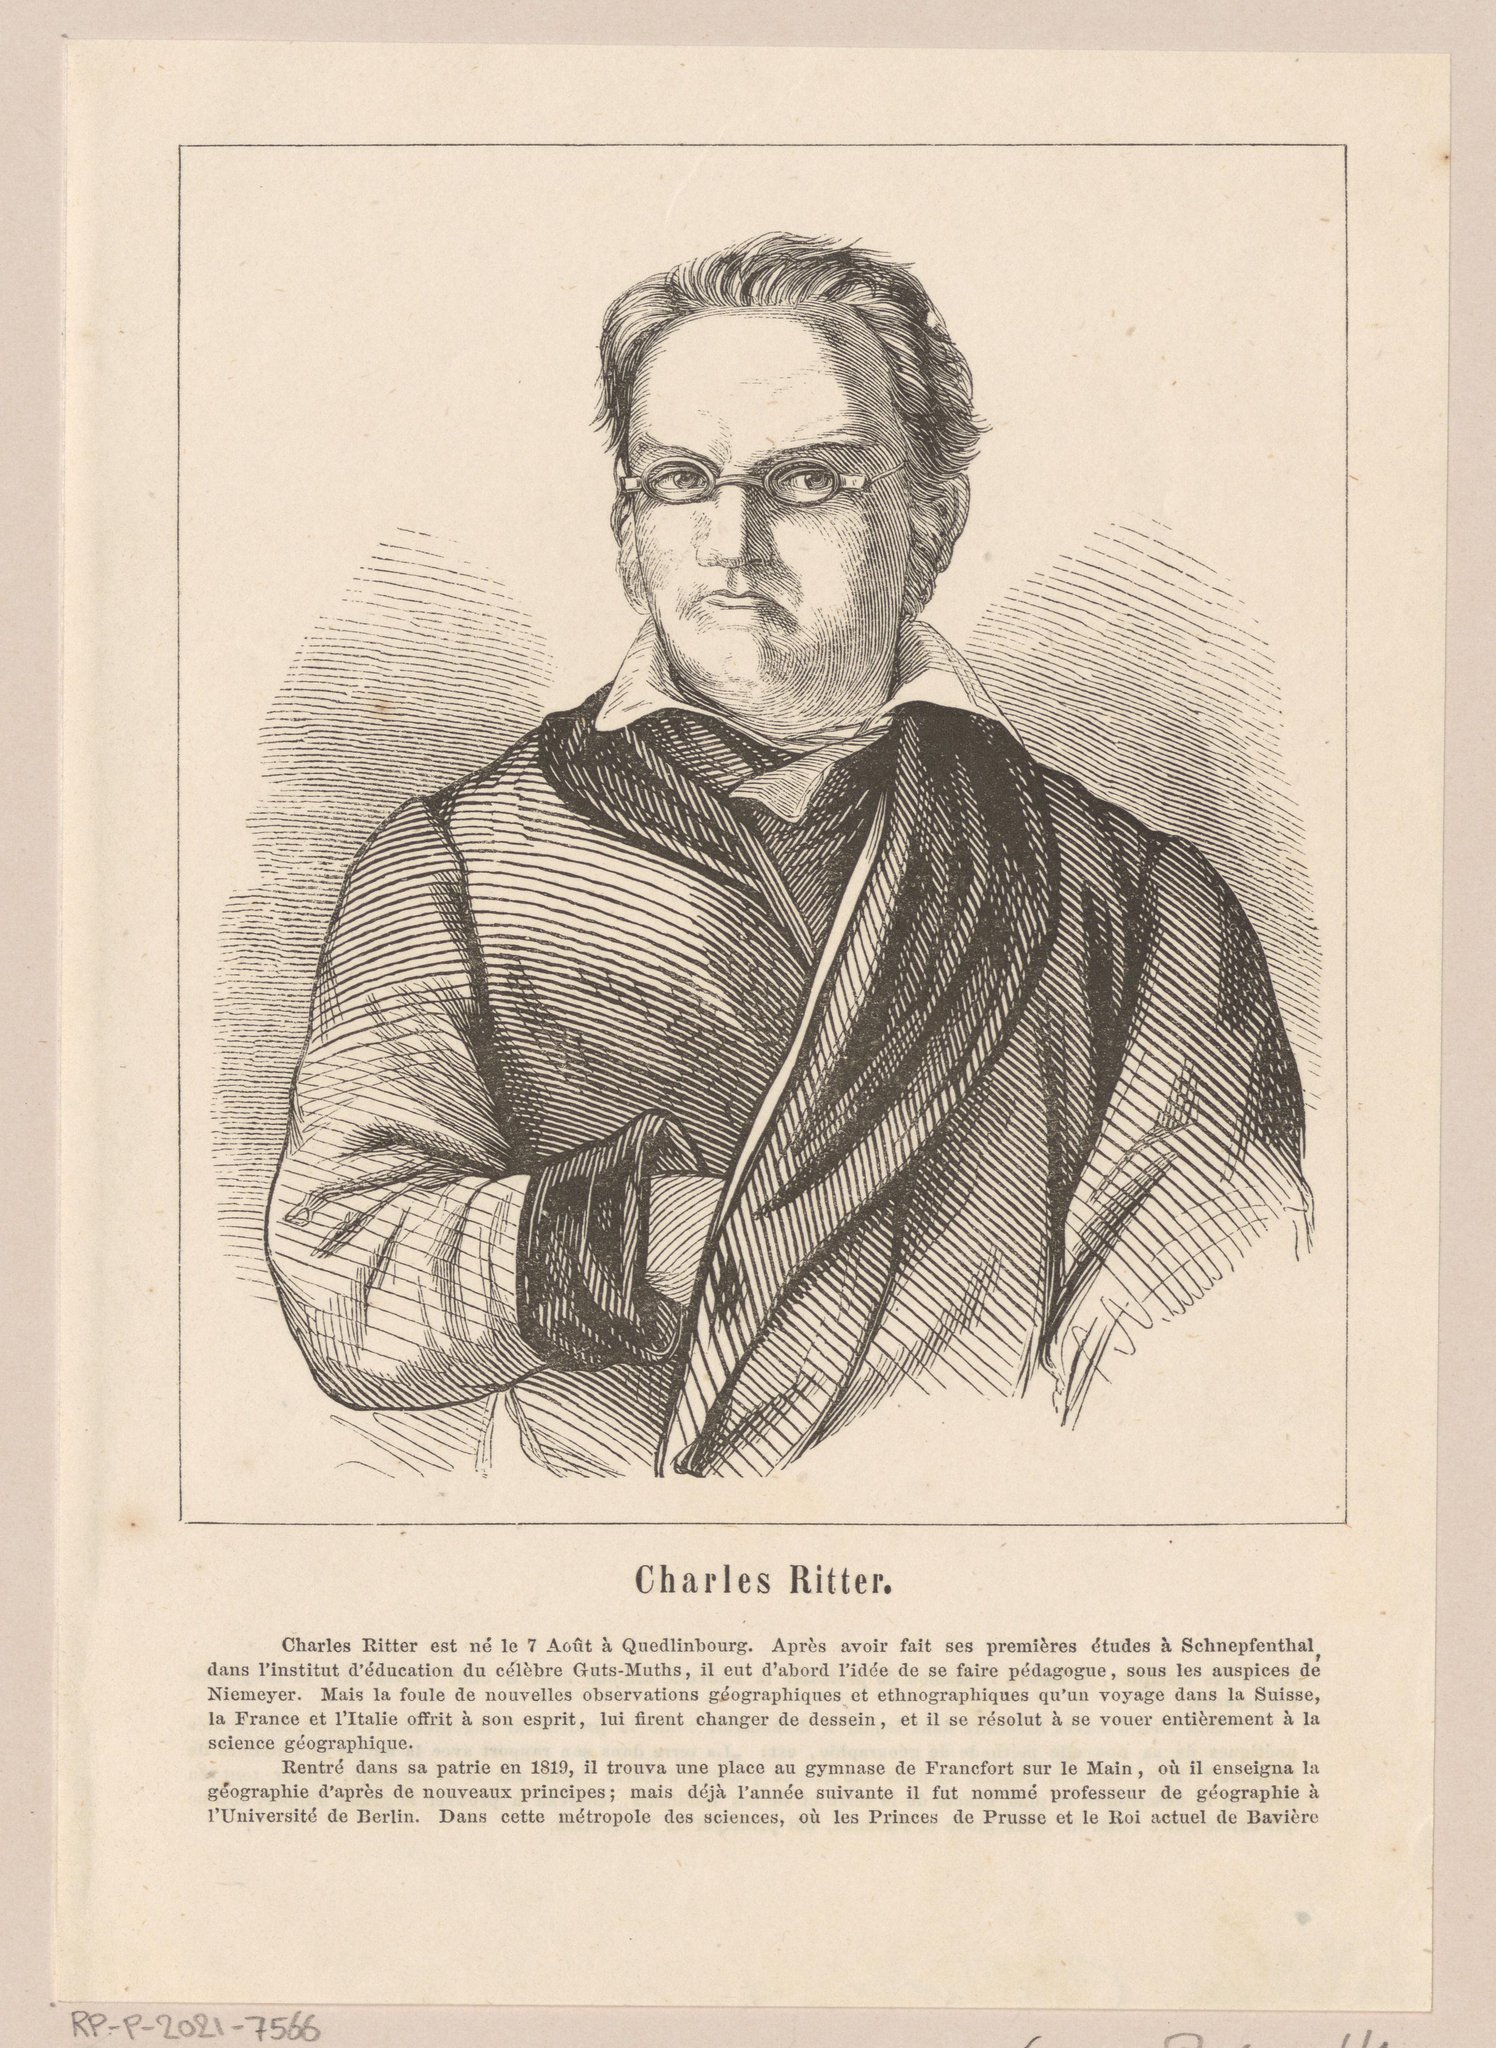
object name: print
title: Portret van Carl Ritter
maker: Anonymous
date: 1819-1899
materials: paper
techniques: letterpress printing, engraving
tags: berlin, historical persons